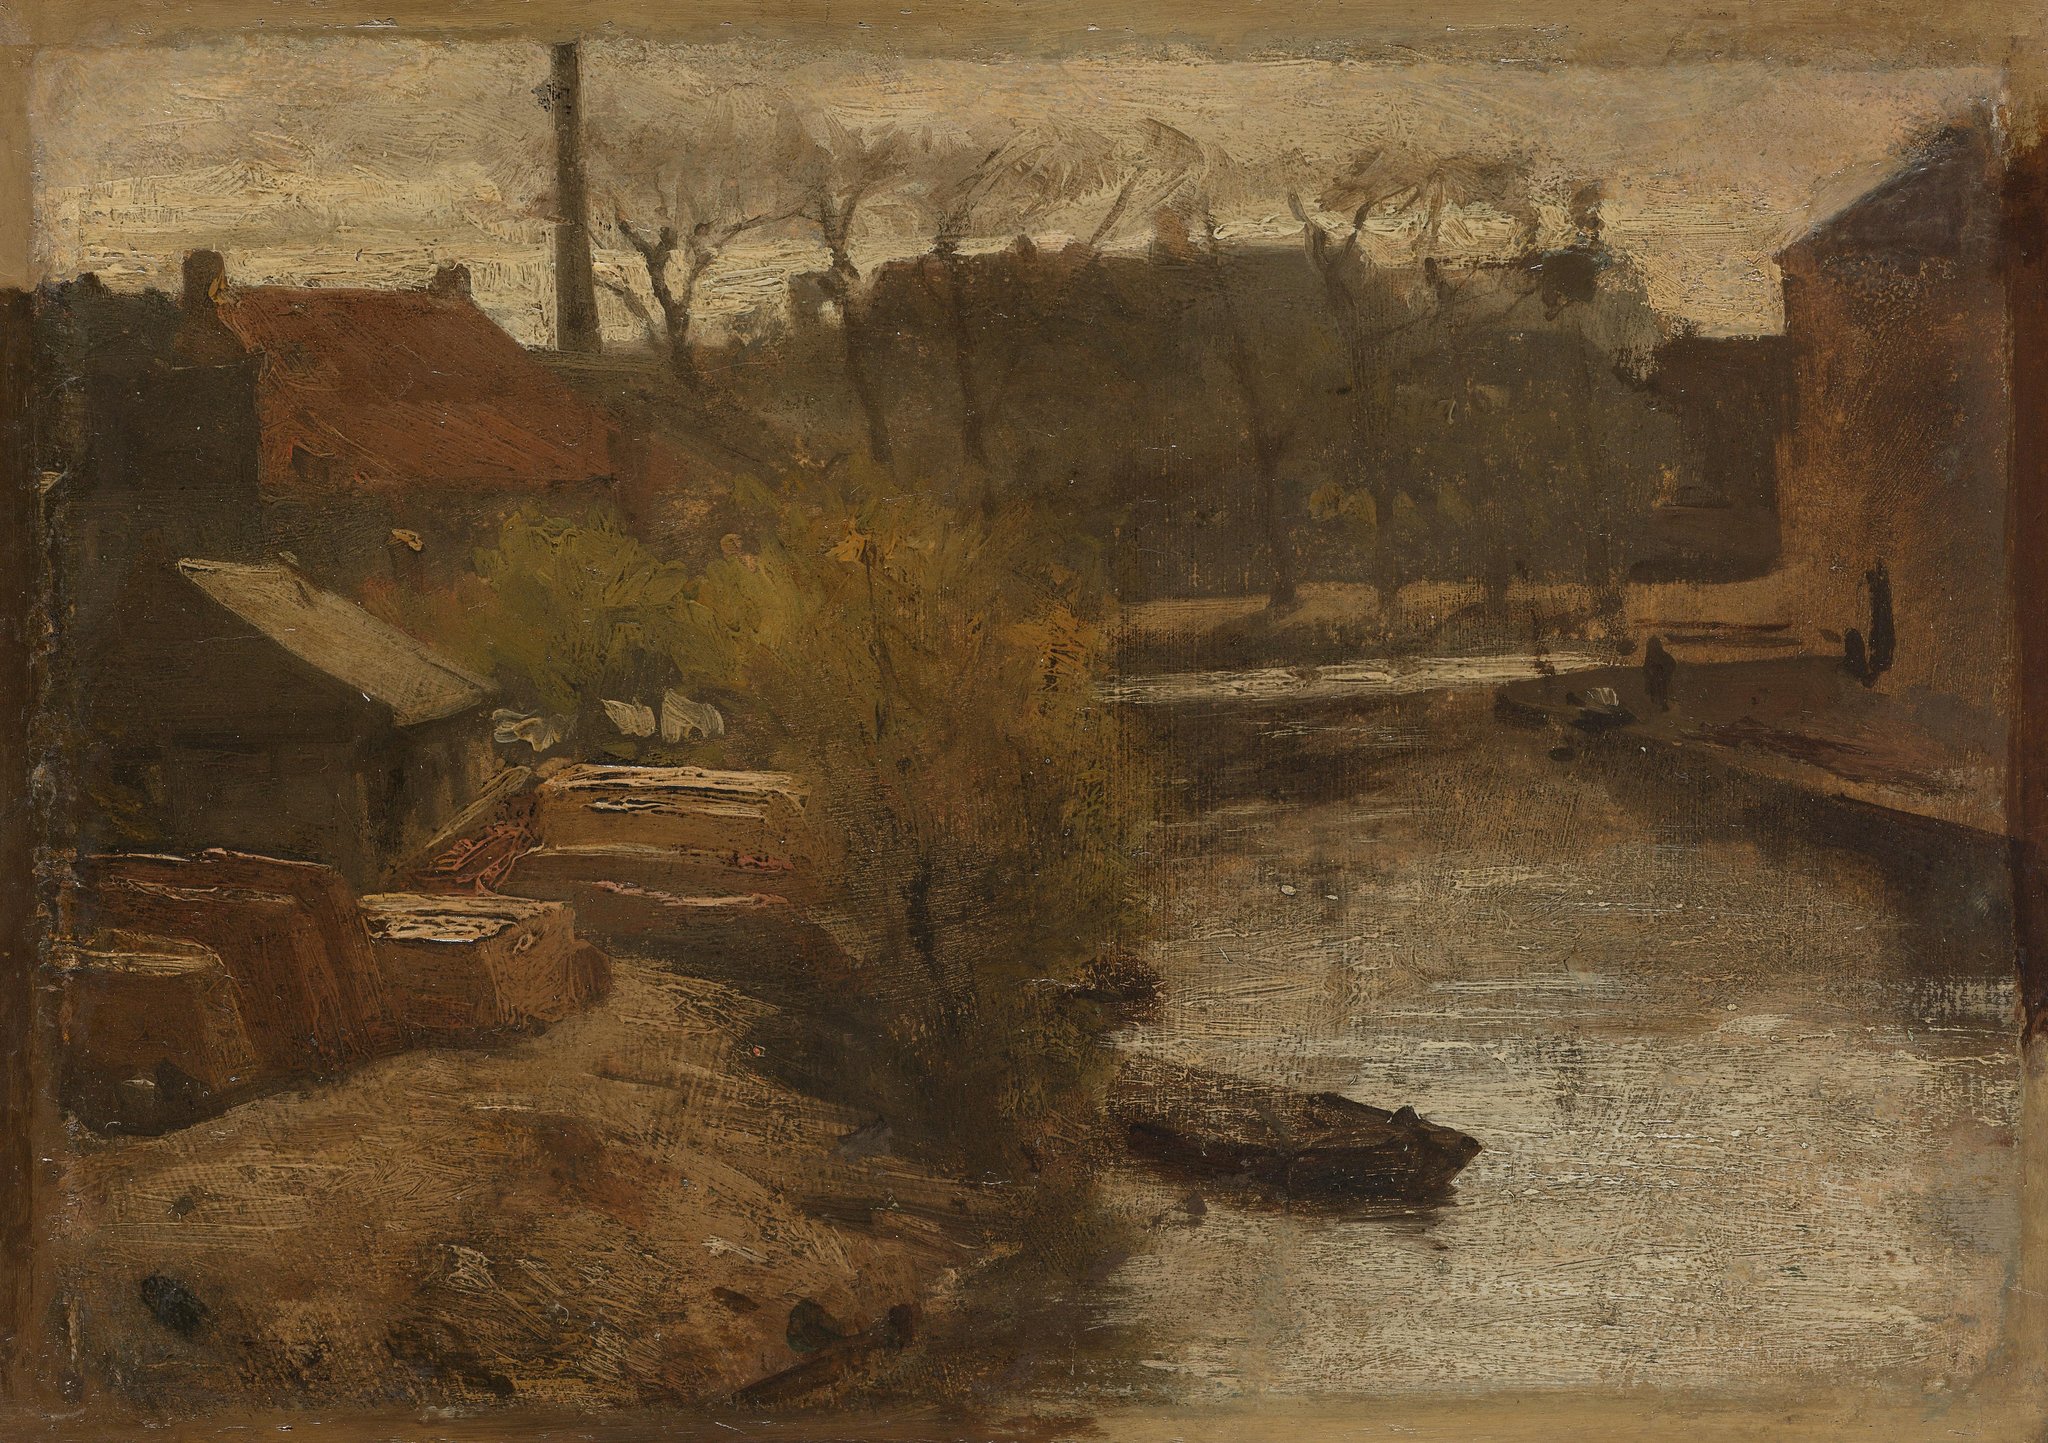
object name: painting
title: The Noord-West-Buitensingel in The Hague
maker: matthijs maris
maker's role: draughtsman, painter, print maker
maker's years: 1839-1917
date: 1863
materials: oil, panel, paper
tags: water course (+ landscape with figures, staffage)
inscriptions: signature: ‘MM.’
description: Gezicht op de Noord-West-Buitensingel te Den Haag. Links huizen, aan de oever van de gracht ligt een boot.